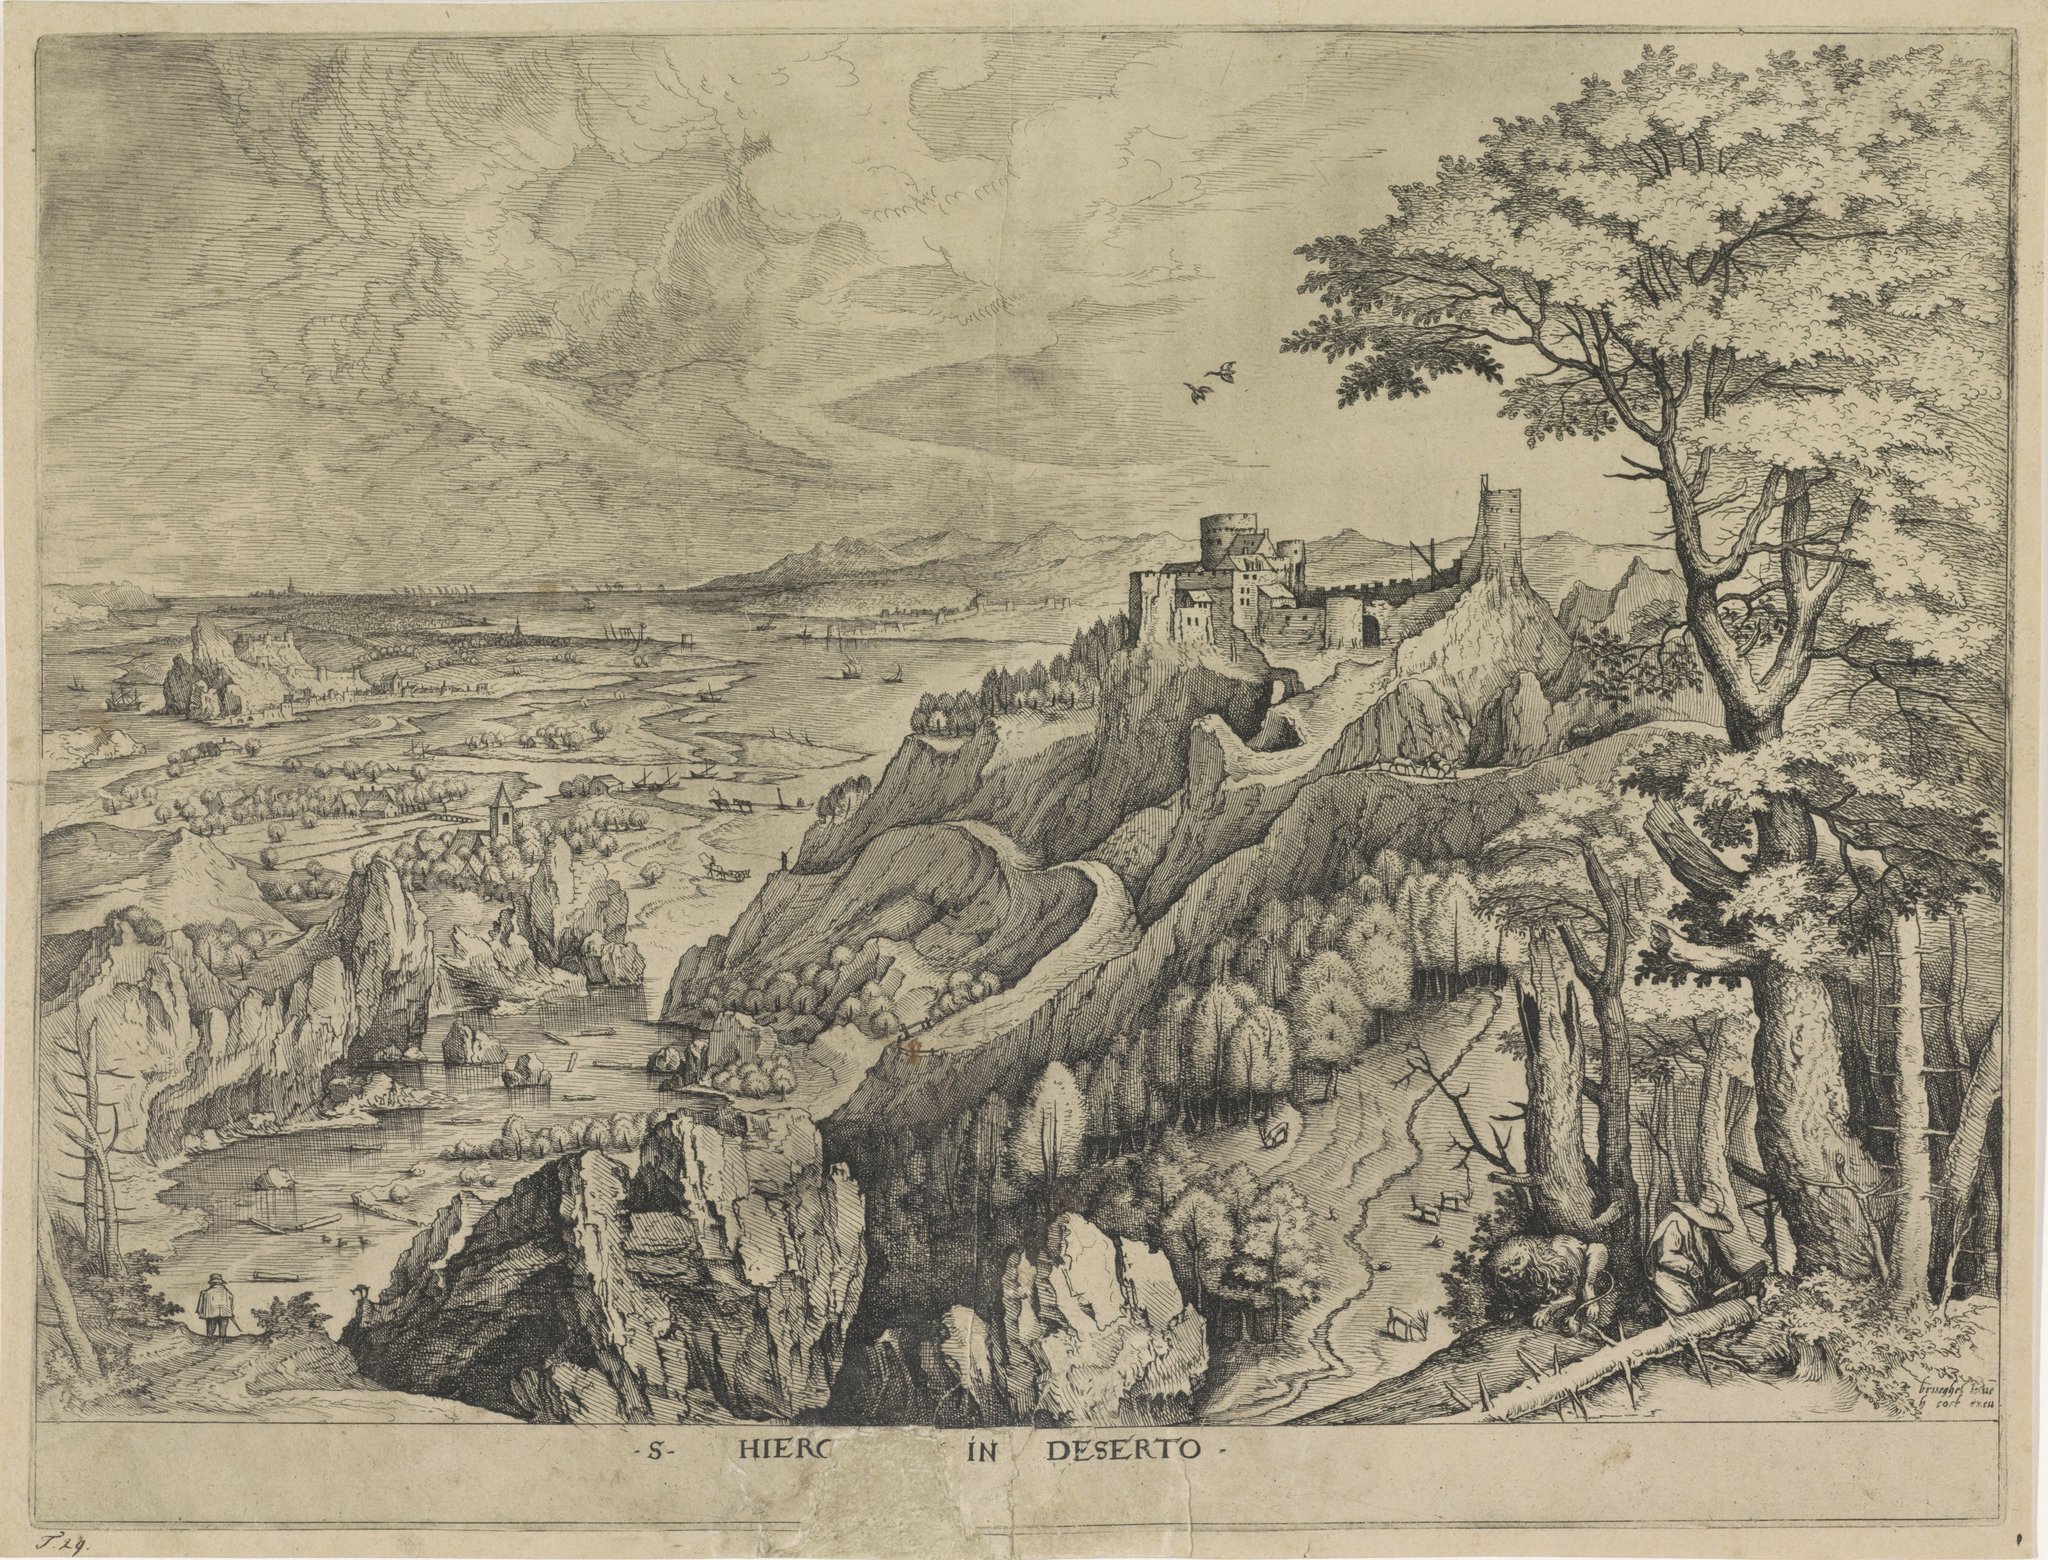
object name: print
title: Landschap met H. Hieronymus in de woestijn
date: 1553-1558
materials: paper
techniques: engraving, etching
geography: antwerp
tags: landscapes in the temperate zone, st. jerome as hermit in a landscape, reading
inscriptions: inscription: ‘T.29.’, collector's mark: Lugt 11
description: Landschap met rechts op de voorgrond de Heilige Hieronymus als boeteling in de woestijn. Naast hem zijn attribuut de leeuw. Links rivieren in het landschap.